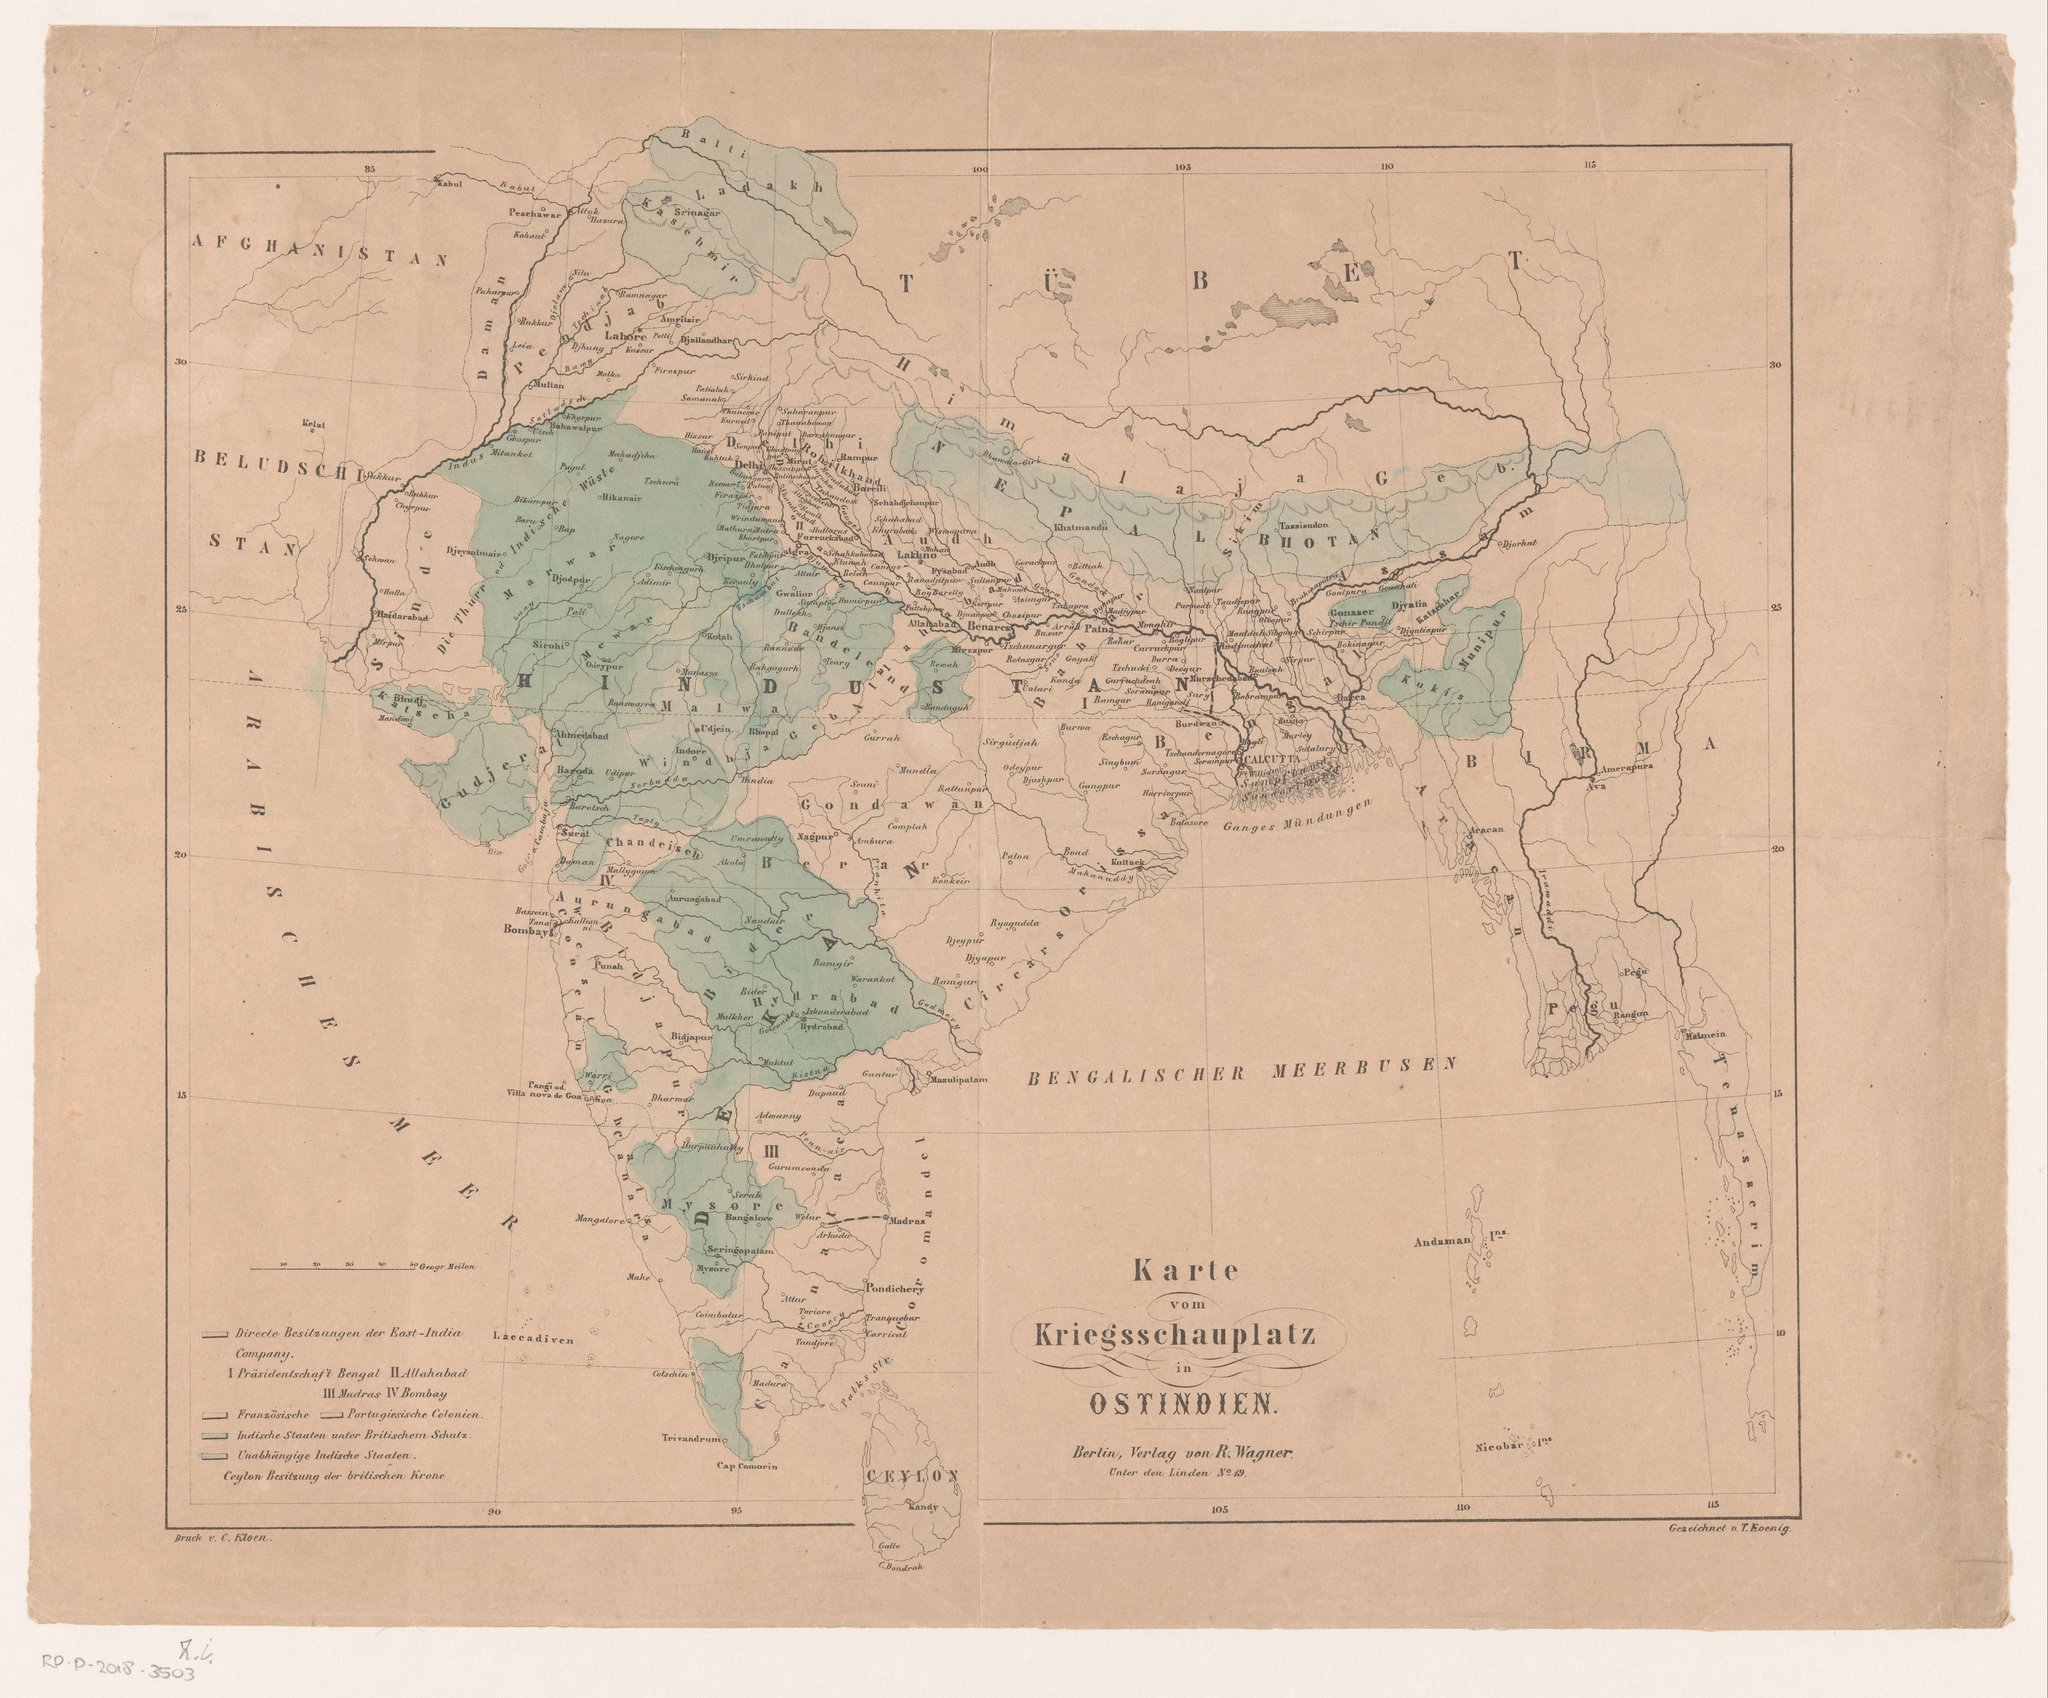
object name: print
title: Karte vom Kriegsschauplatz in Ostindien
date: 1850-1899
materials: paper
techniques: hand coloring, lithograph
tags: imperialism, maps of separate countries or regions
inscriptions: collector's mark: Lugt 2228